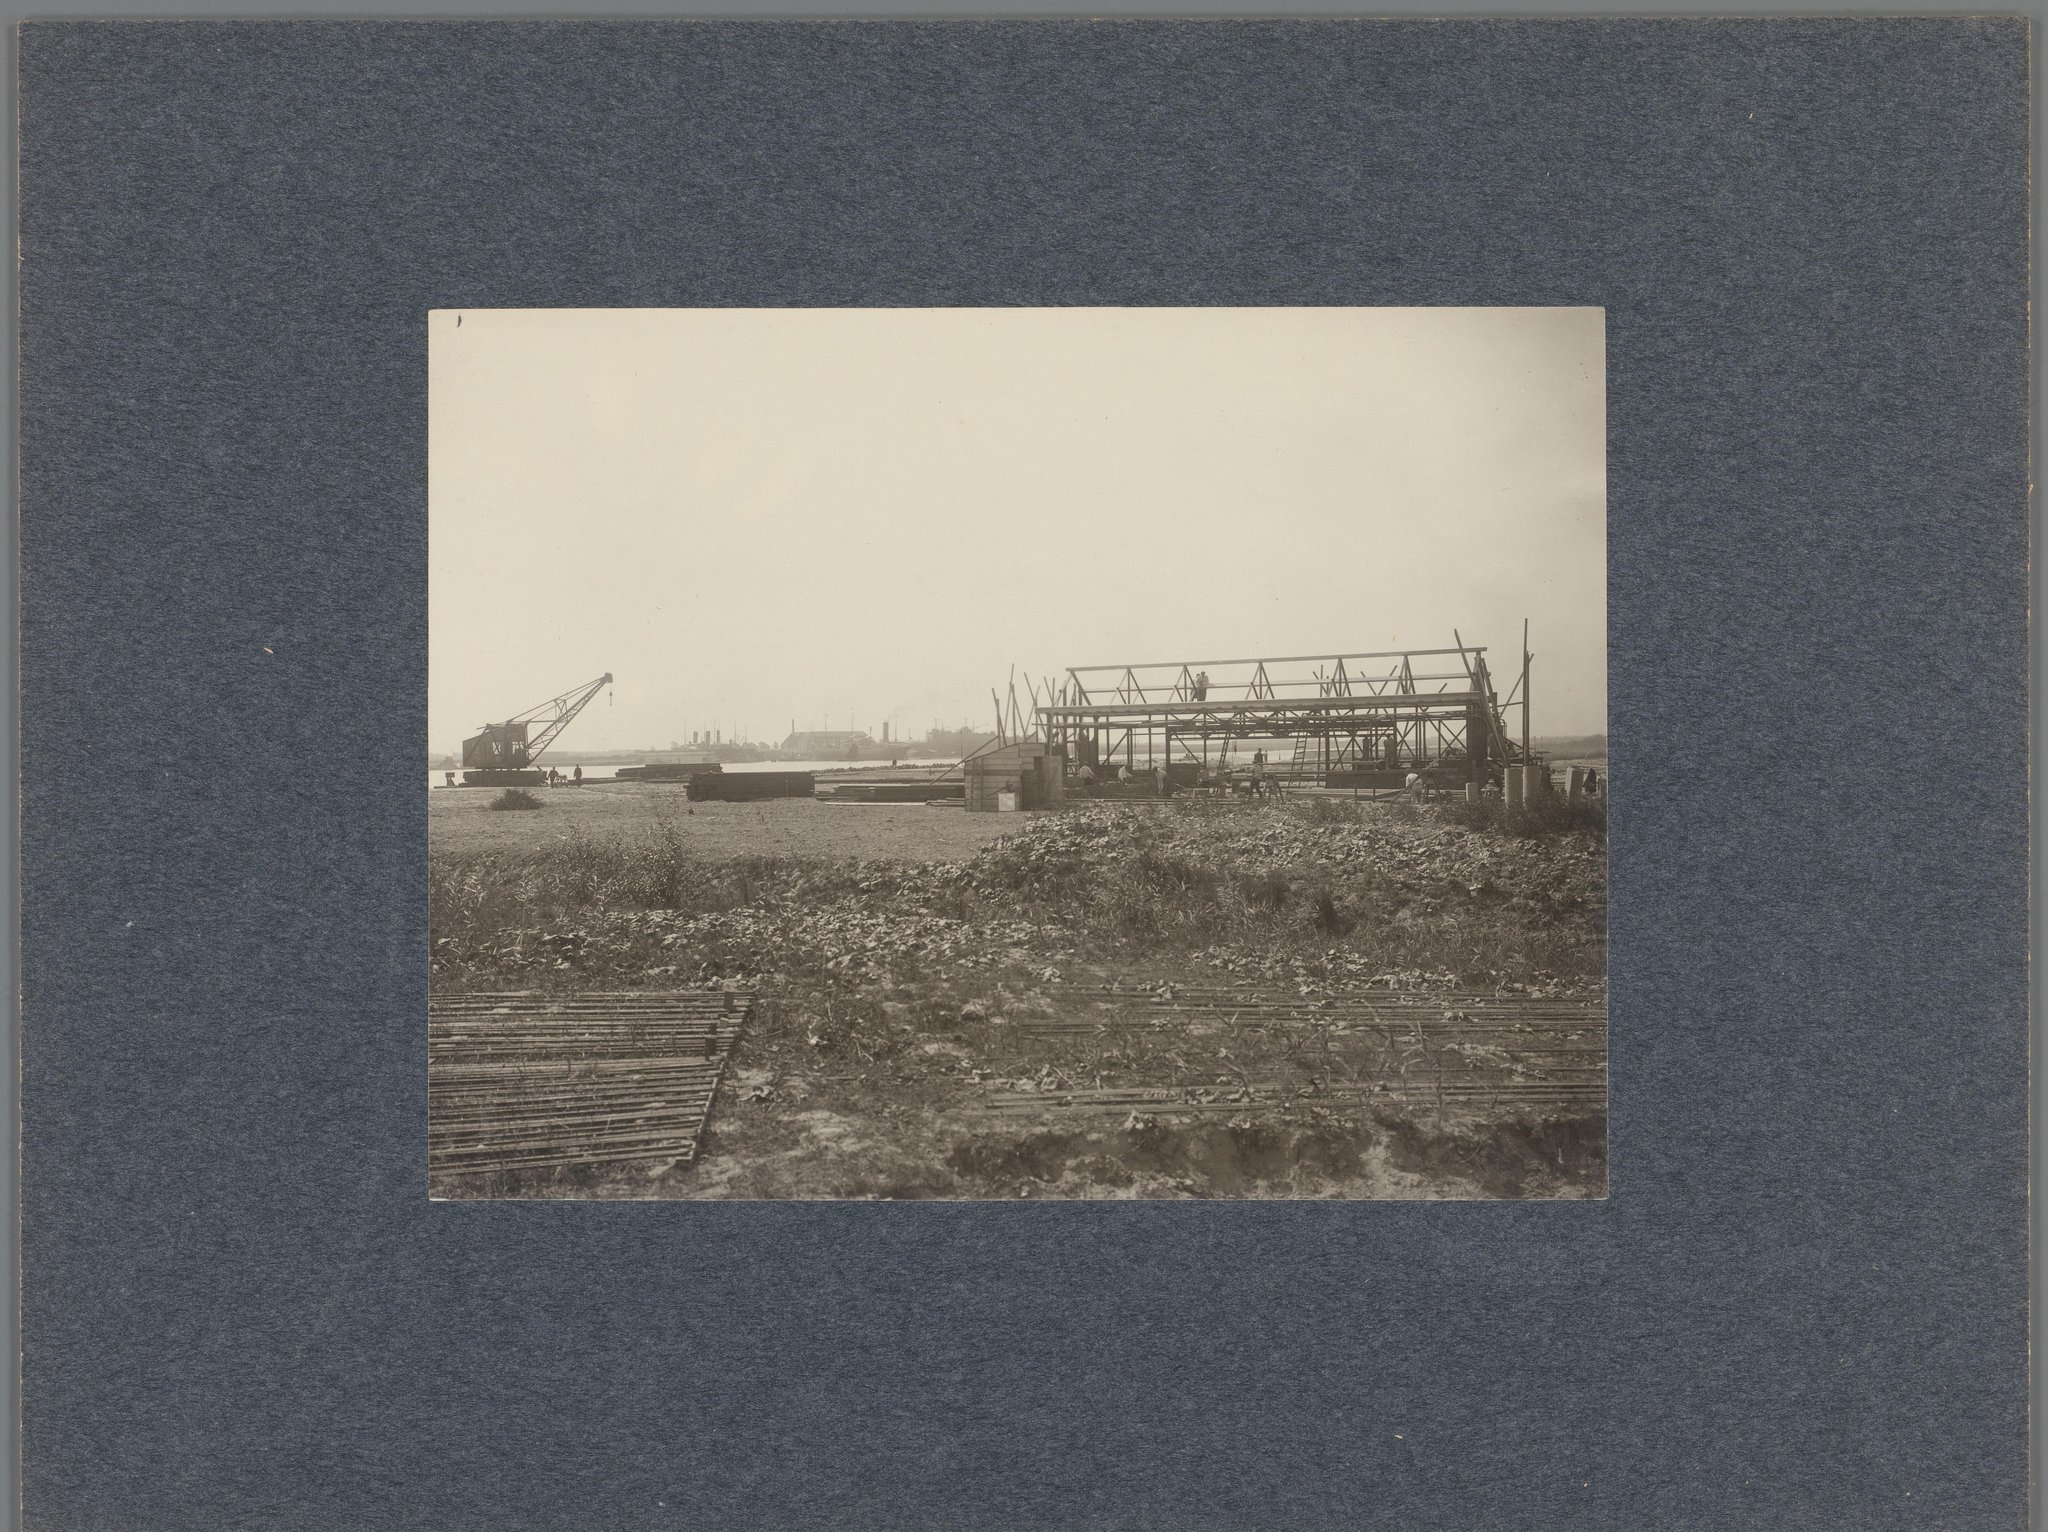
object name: photograph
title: Bouw van een kleine fabriek of opslagplaats in de Keilehaven, op de achtergrond de Maas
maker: willem sr. bleuzé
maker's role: fotograaf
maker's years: 1873-1948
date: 1912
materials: paper, cardboard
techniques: gelatin silver print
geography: rotterdam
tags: factory-building, bridge, building-site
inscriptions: address: ‘W. BLEUZÉ/ ROTTERDAM/ JONKER FRANSSTRAAT 66’